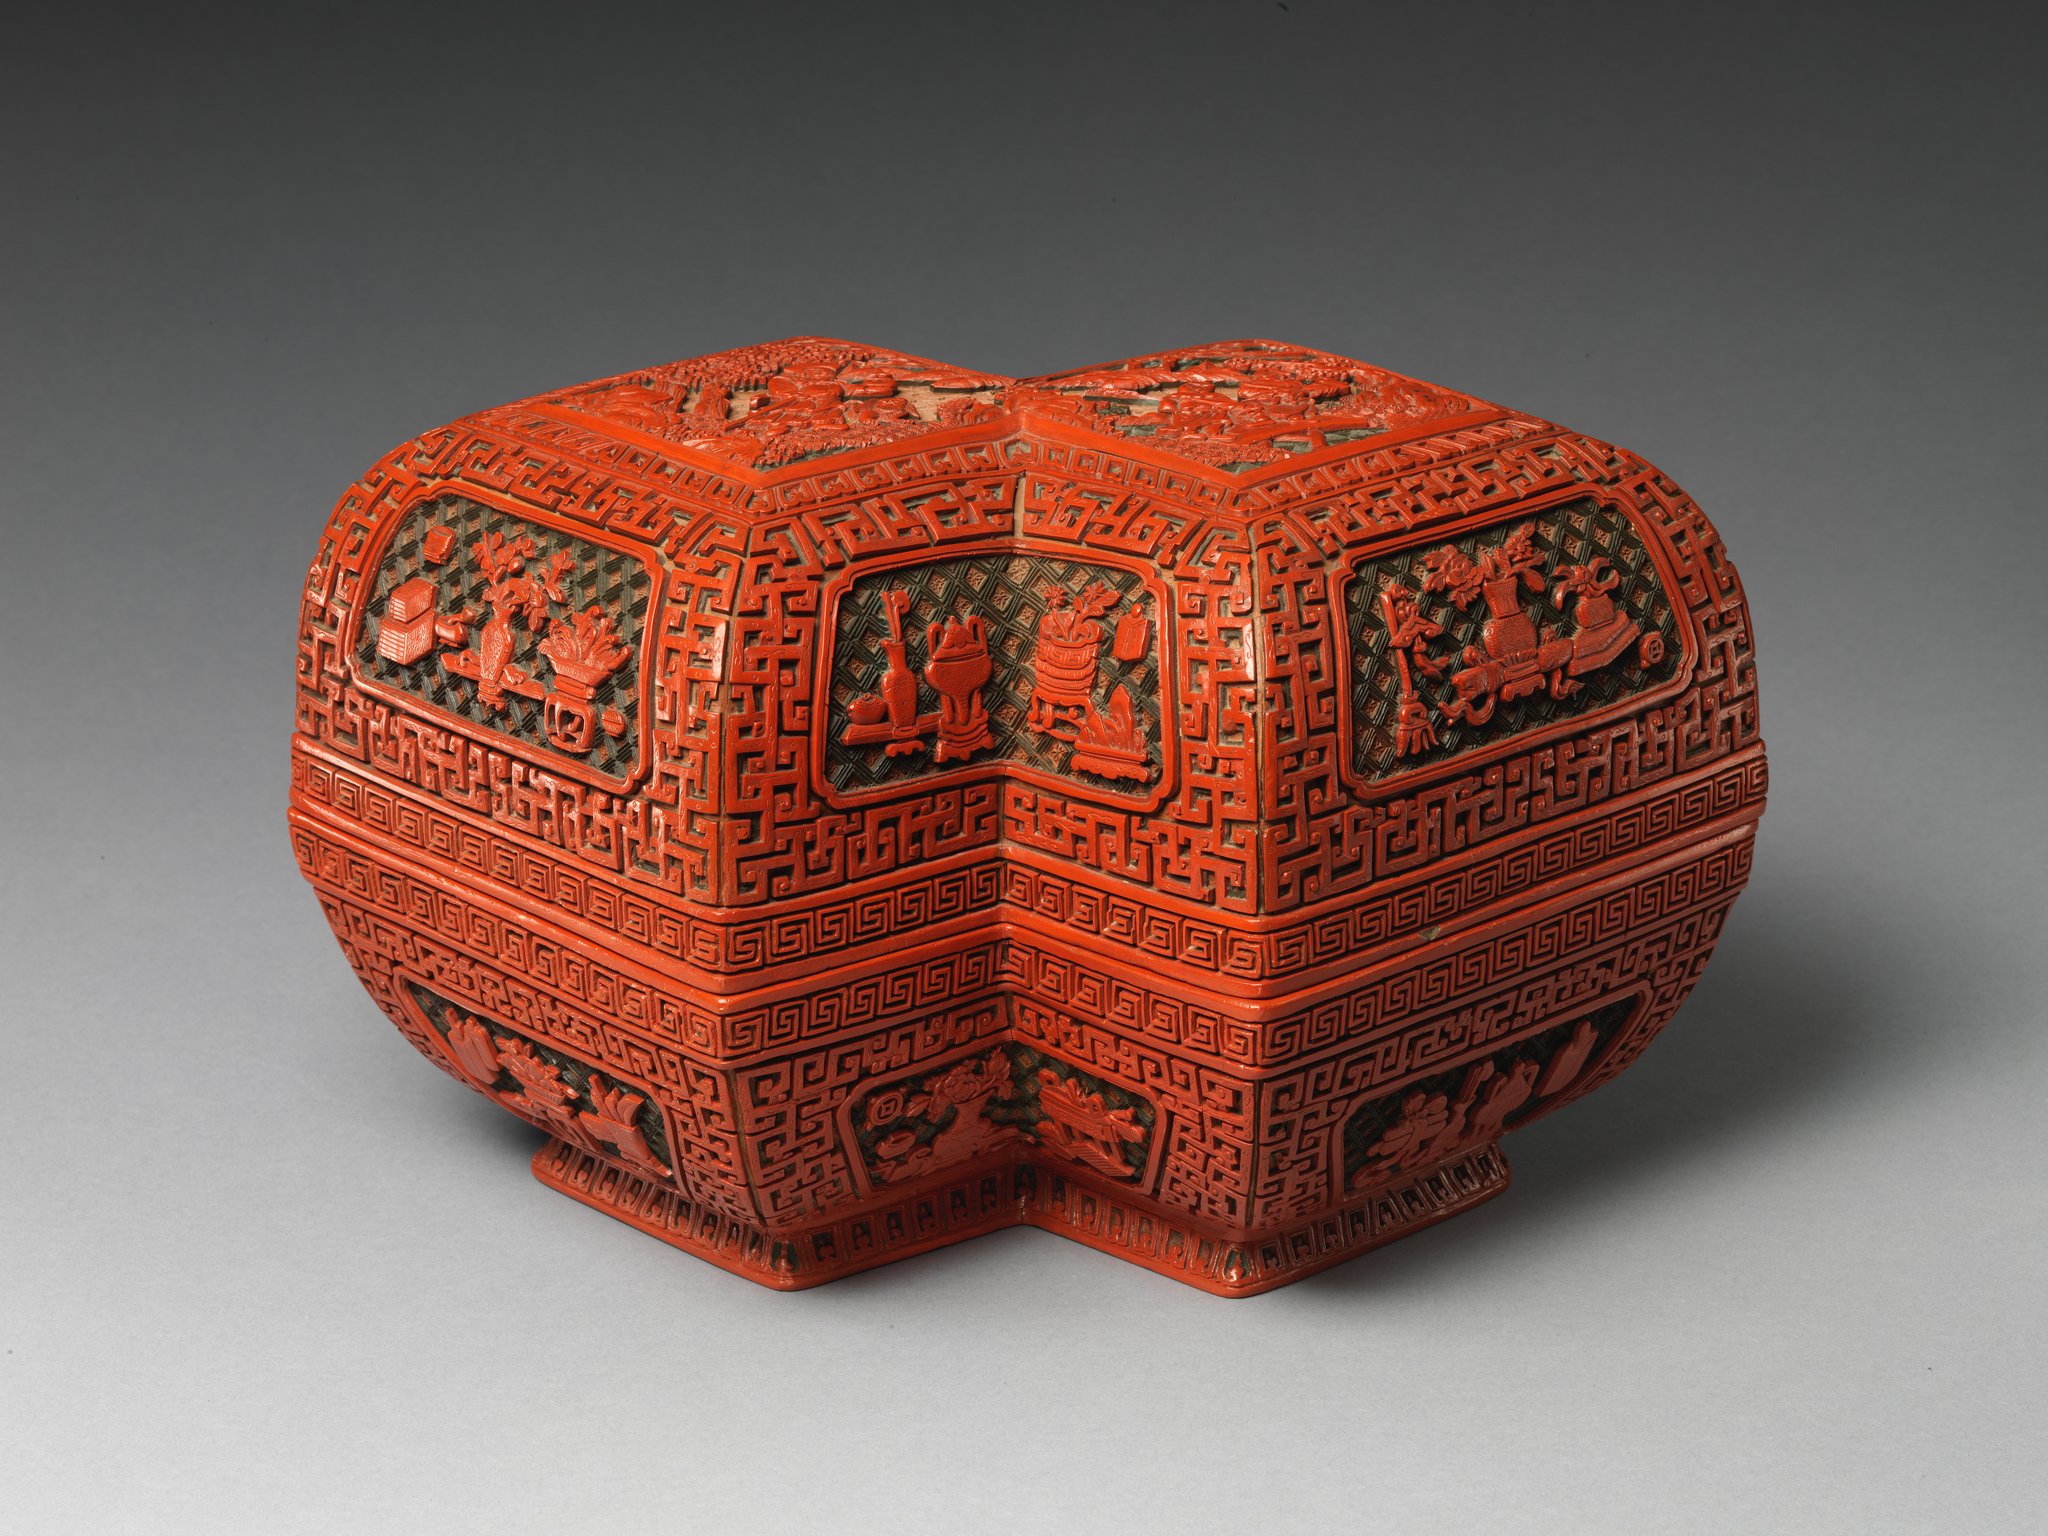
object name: box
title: Lozenge box with scene of treasure tributary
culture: chinese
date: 1701-1800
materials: lacquer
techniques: carving